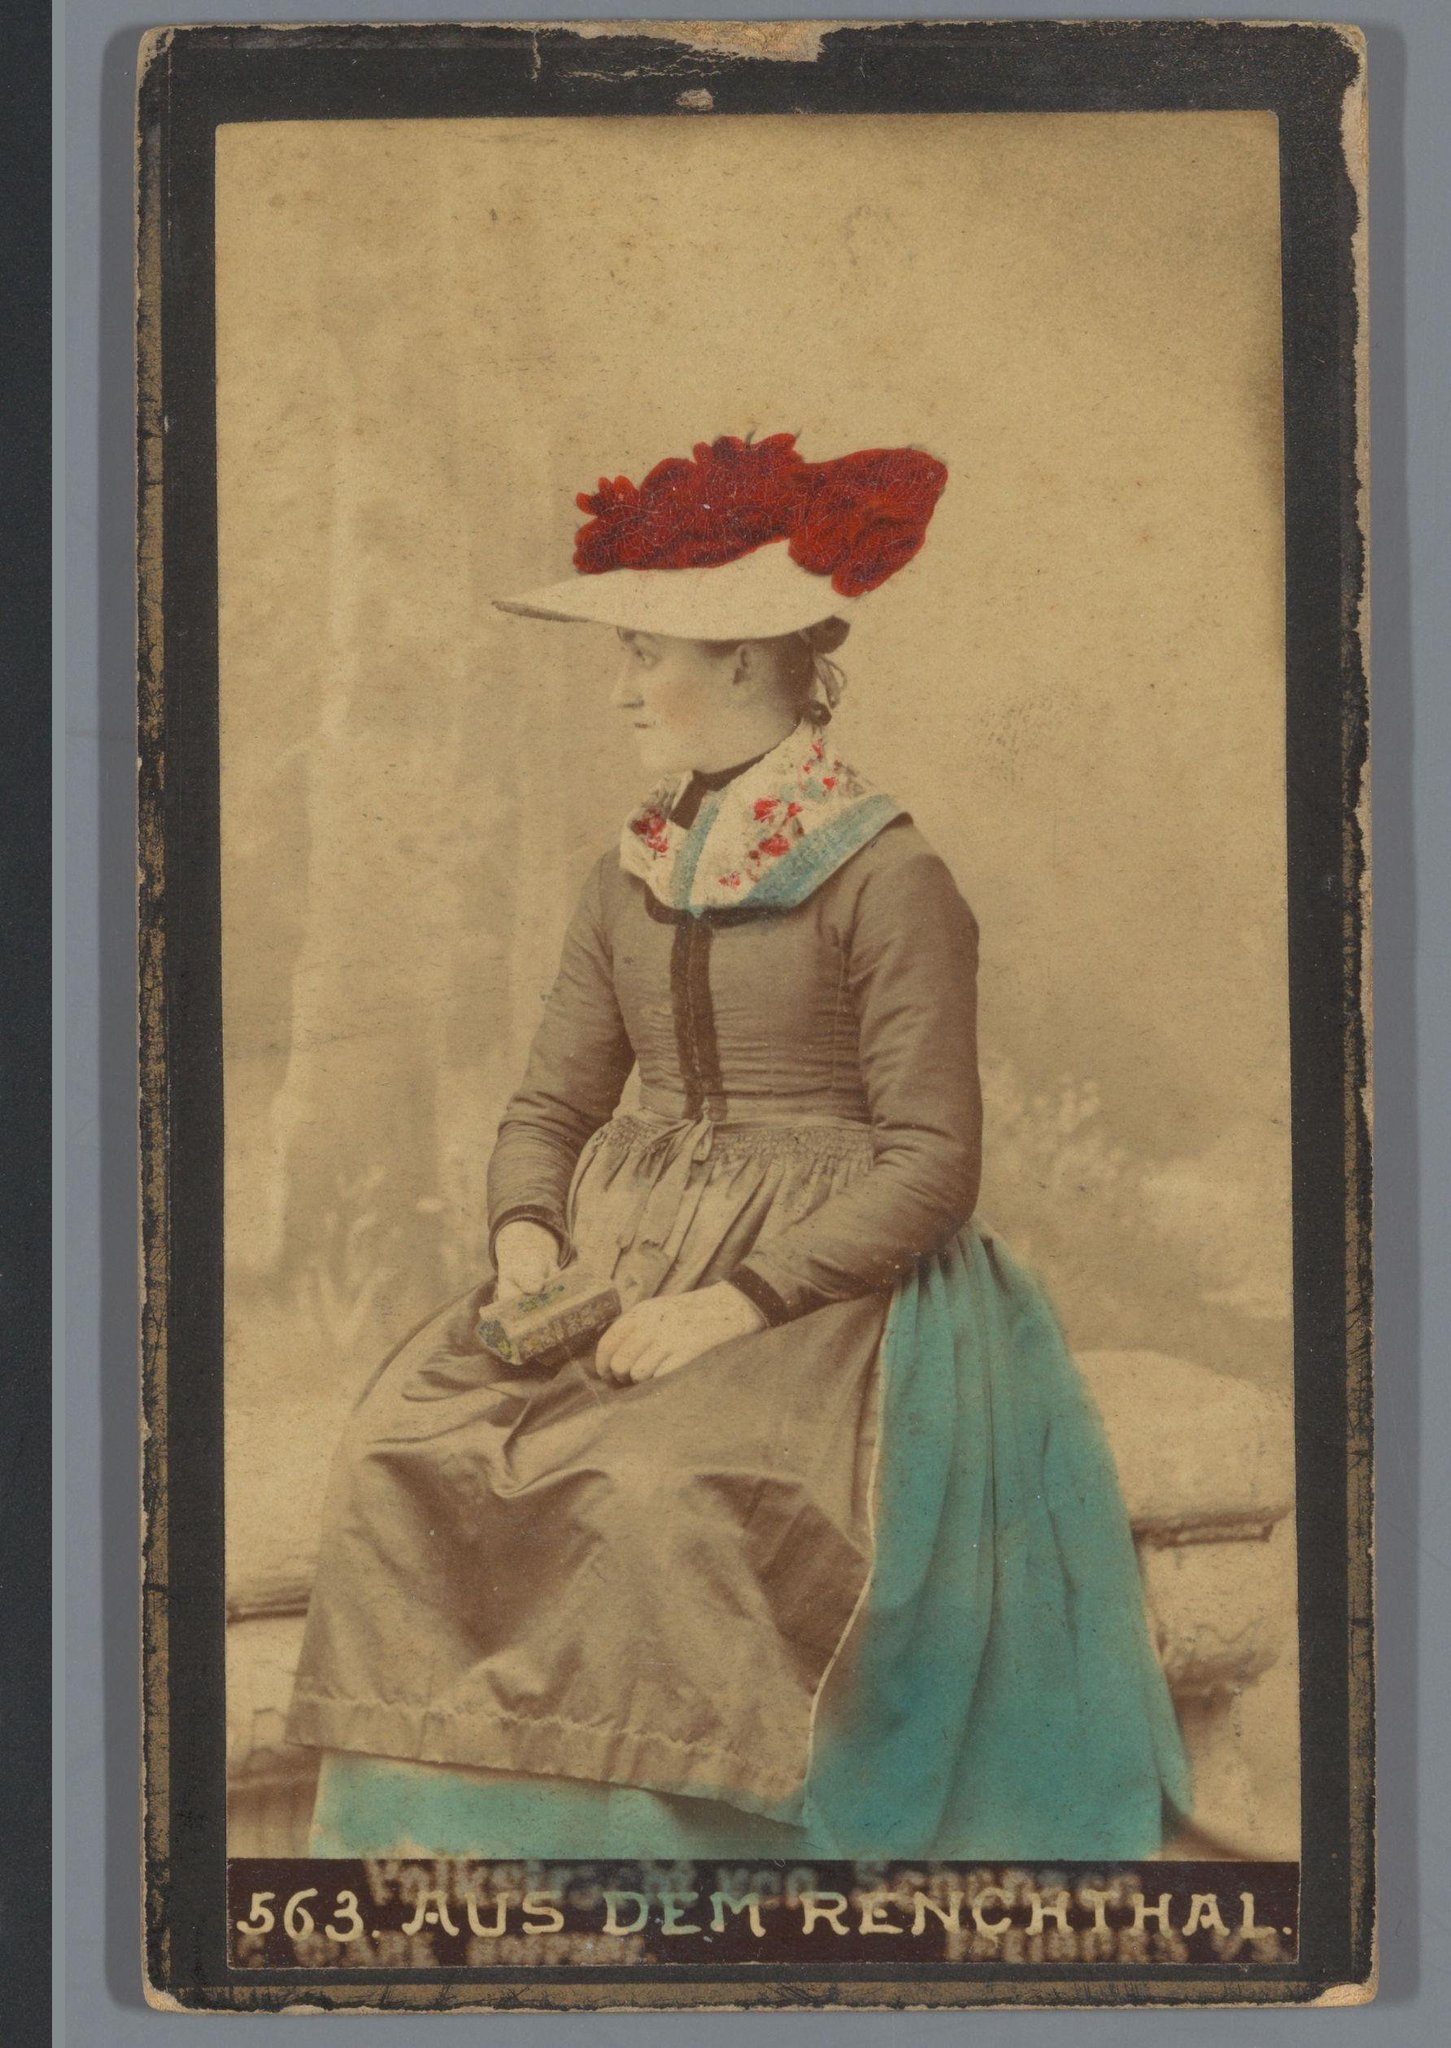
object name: carte de visite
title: Portret van een onbekende vrouw in klederdracht uit het Renchdal, Duitsland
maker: c. clare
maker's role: fotograaf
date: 1854-1885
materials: cardboard, paper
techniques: albumen print, hand coloring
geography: freiburg im breisgau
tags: adult woman, anonymous historical person portrayed, folk costume, regional costume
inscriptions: address: ‘FREIBURG i/B/ Holzmarktplatz 8a.’, inscription: ‘Prämiirt mit den höchsten Auszeichnungen./ Grösste Auswahl von Ansichten:/ des badischen Oberlandes, (...)’, number: ‘563.’